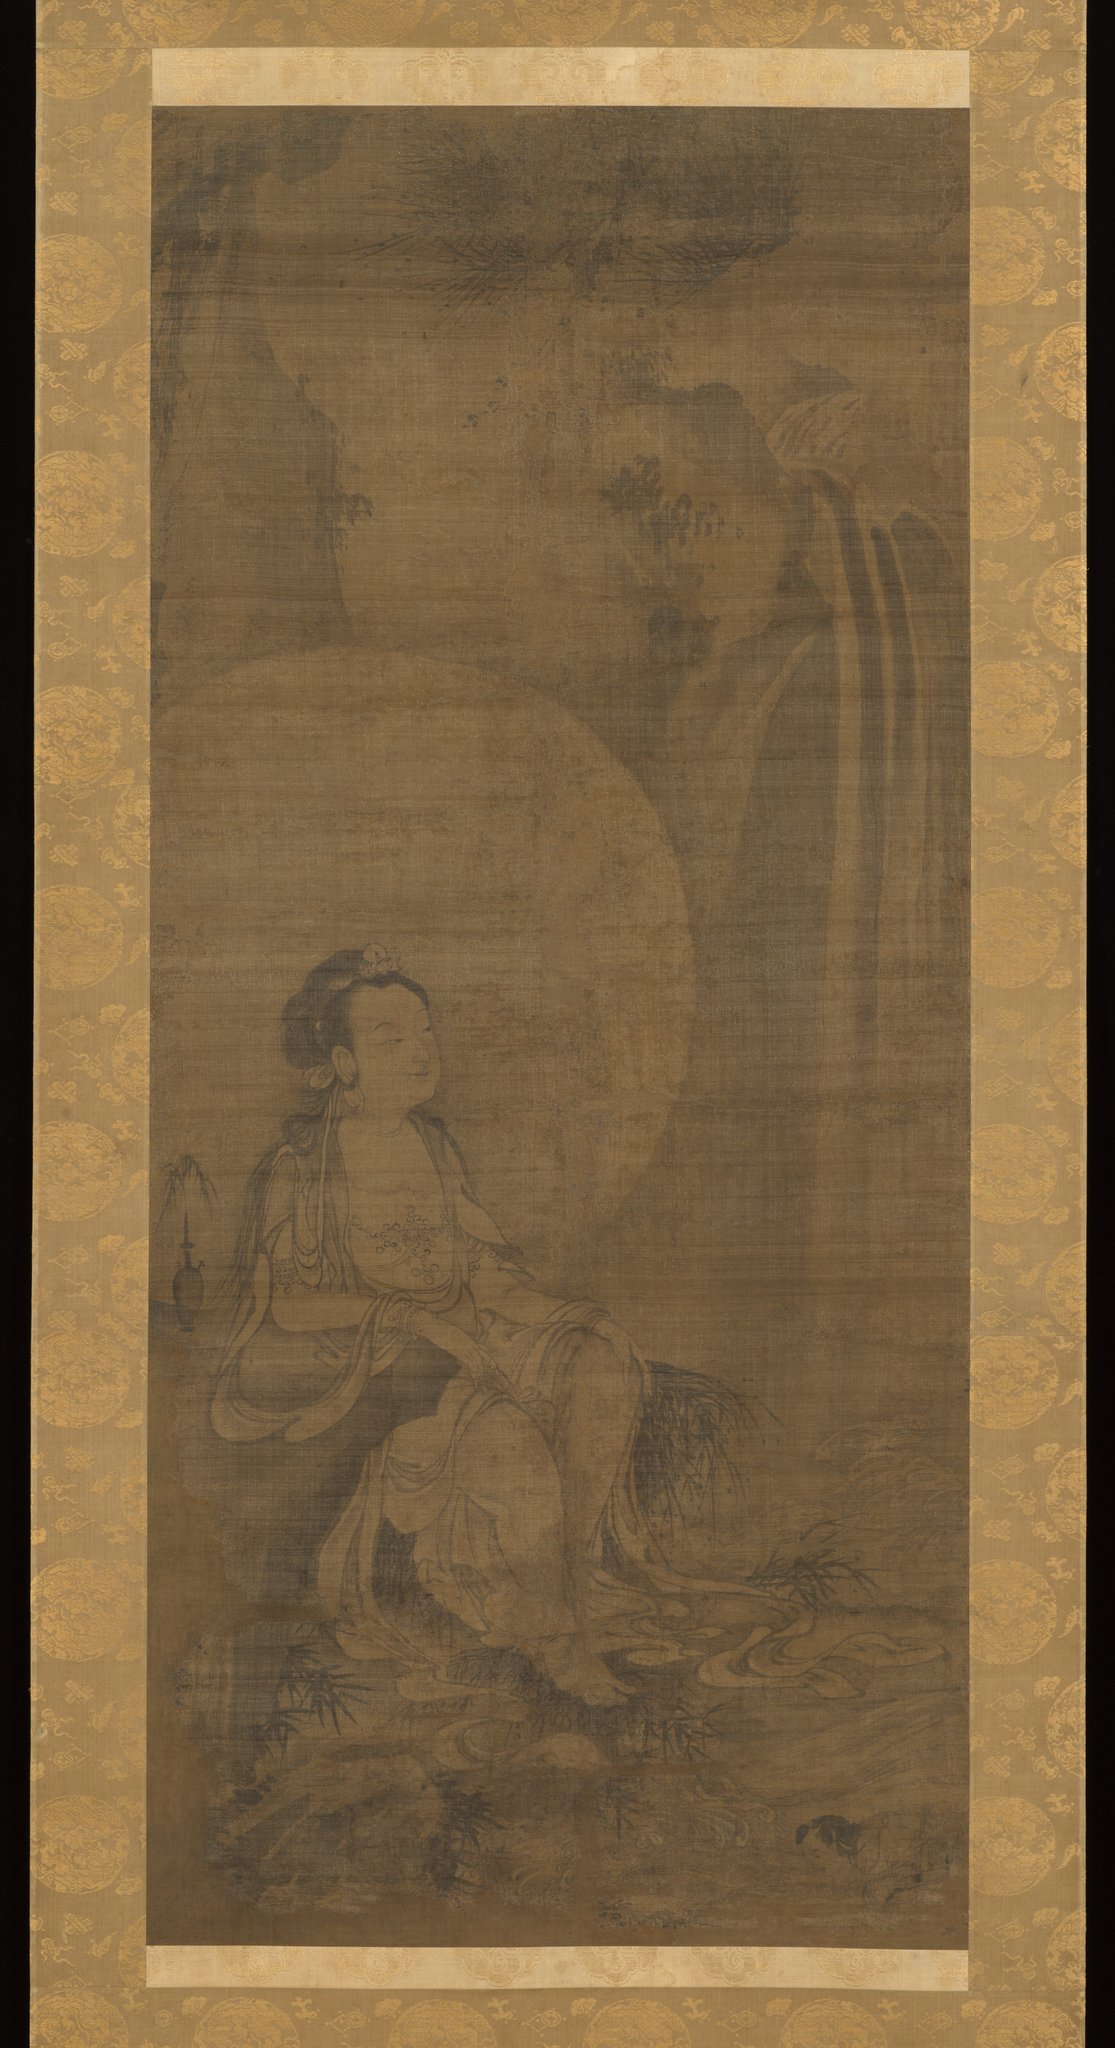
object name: hanging scroll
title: White-robed Kannon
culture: japanese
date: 1301-1400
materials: ink, silk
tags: waterfalls,avalokiteshvara,bodhisattvas